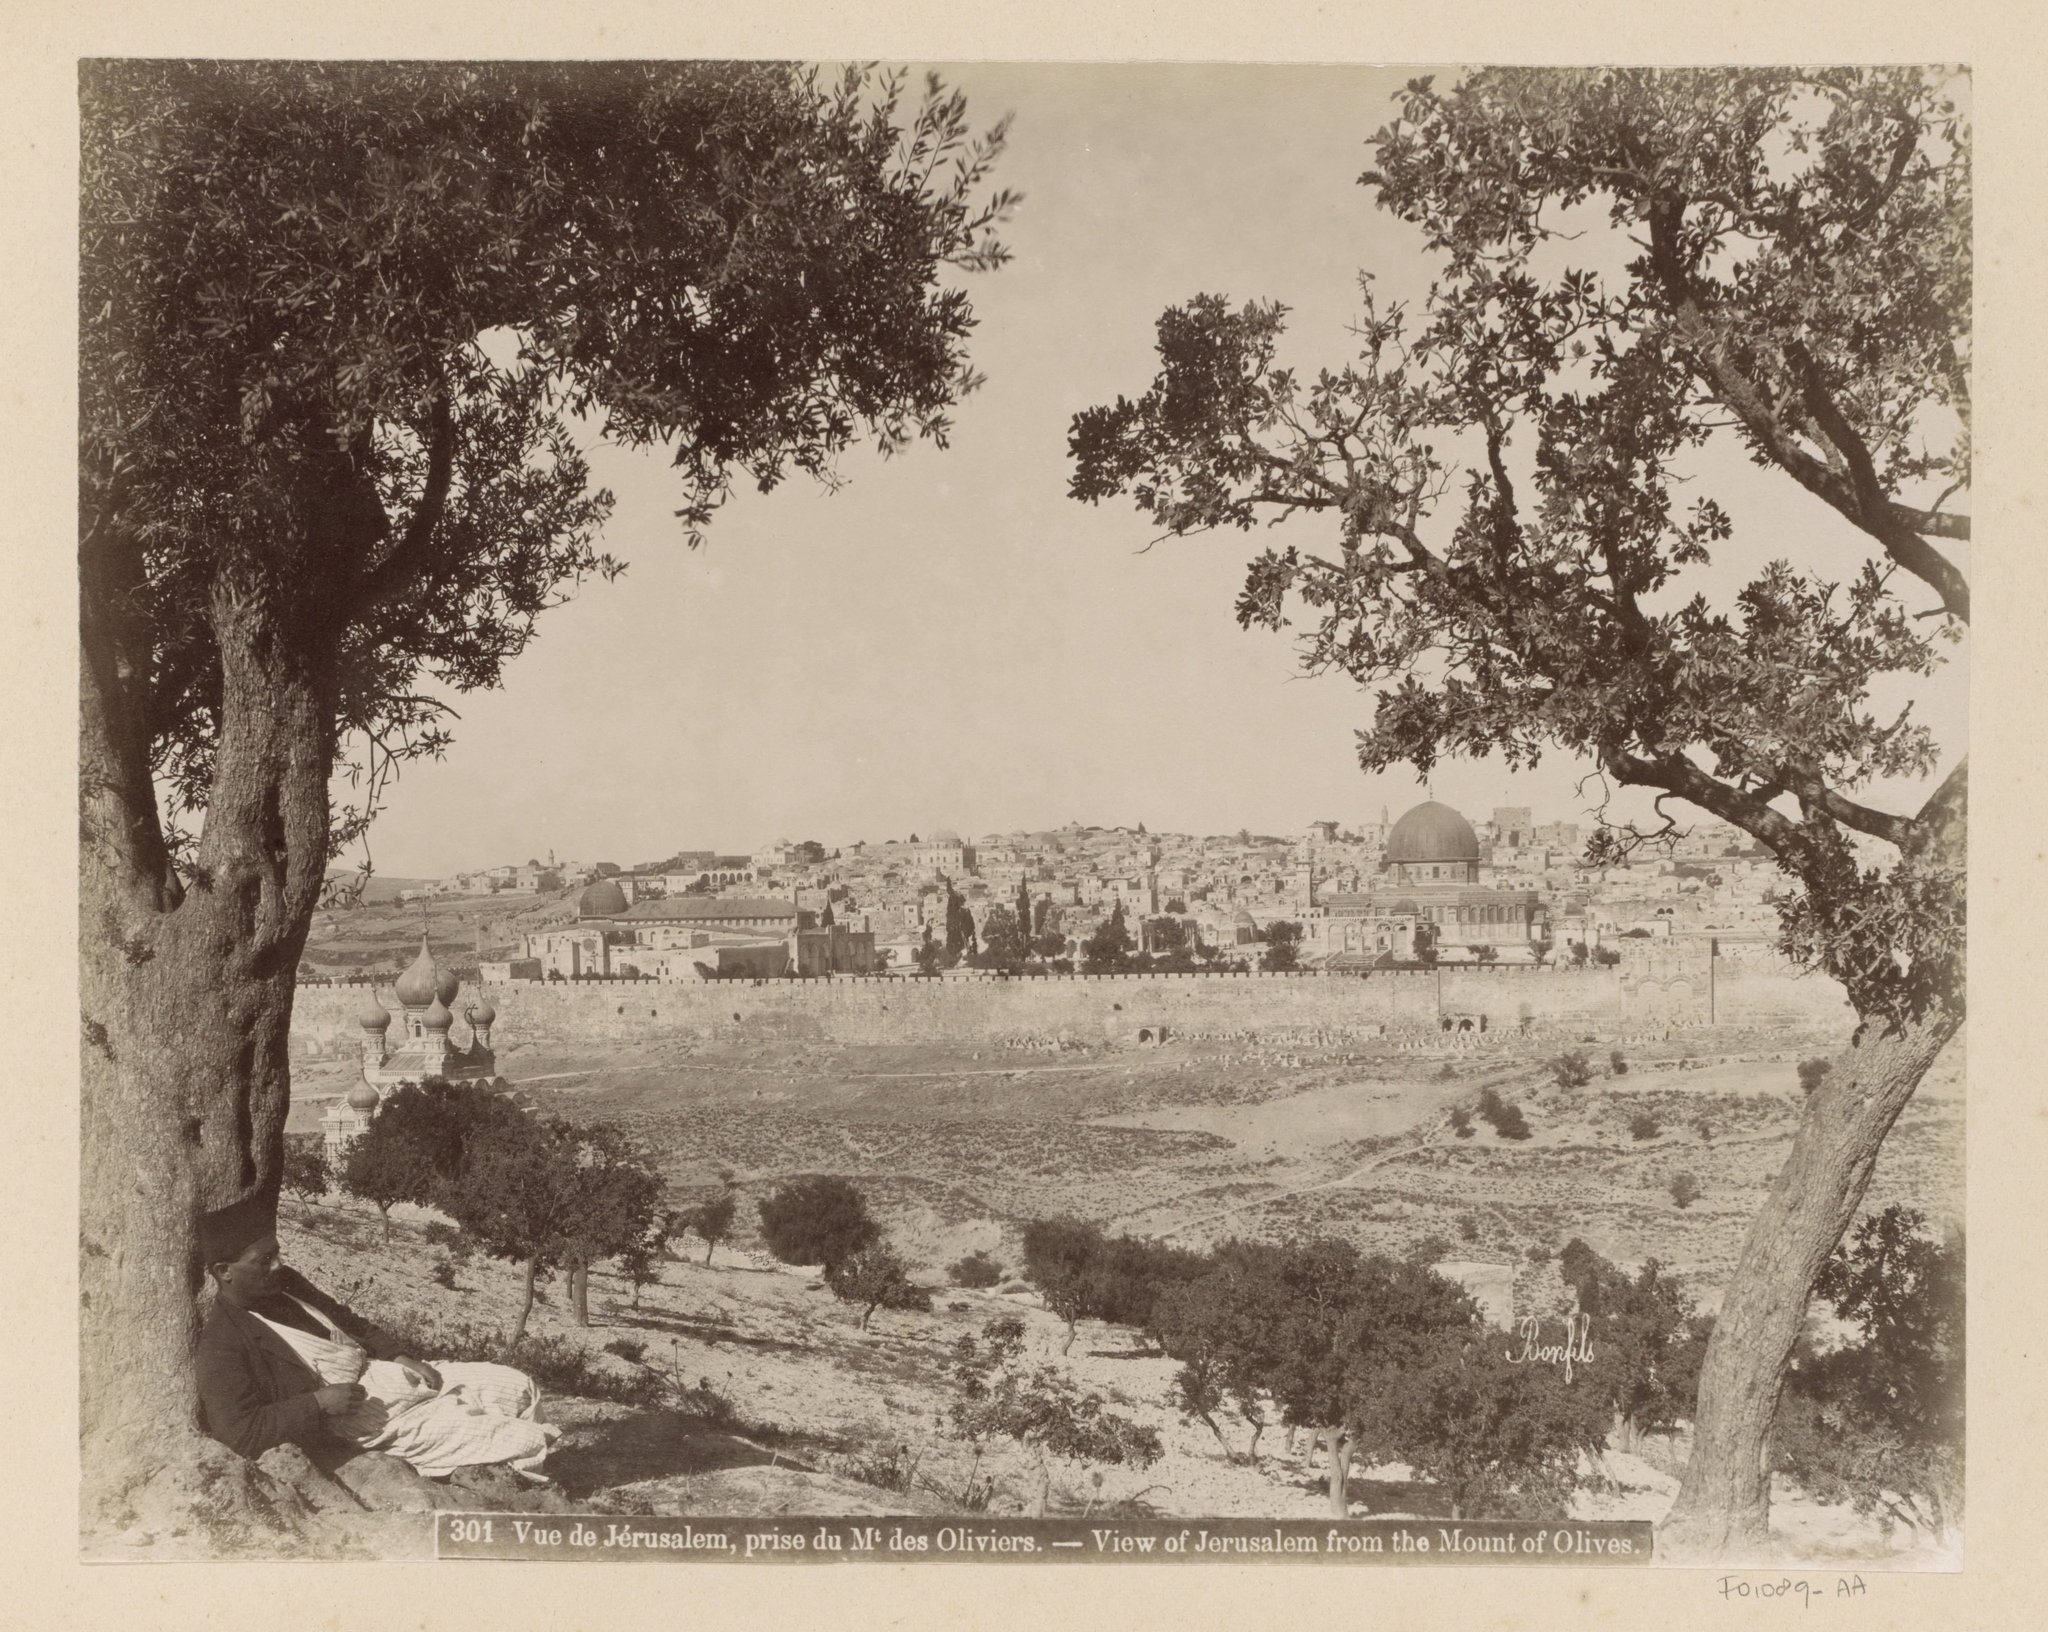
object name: photograph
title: Vue de Jérusalem, prise du Mt des Oliviers.- View of Jerusalem from the Mount of Olives.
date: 1867-1895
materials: cardboard, paper, photographic support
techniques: albumen print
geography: jerusalem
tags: city-walls, temple, shrine ~ islam, mohammedanism, prospect of city, town panorama, silhouette of city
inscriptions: negative number: ‘301’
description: Onderdeel van Reisalbum met foto's van Jeruzalem en andere bijbelse plaatsen.